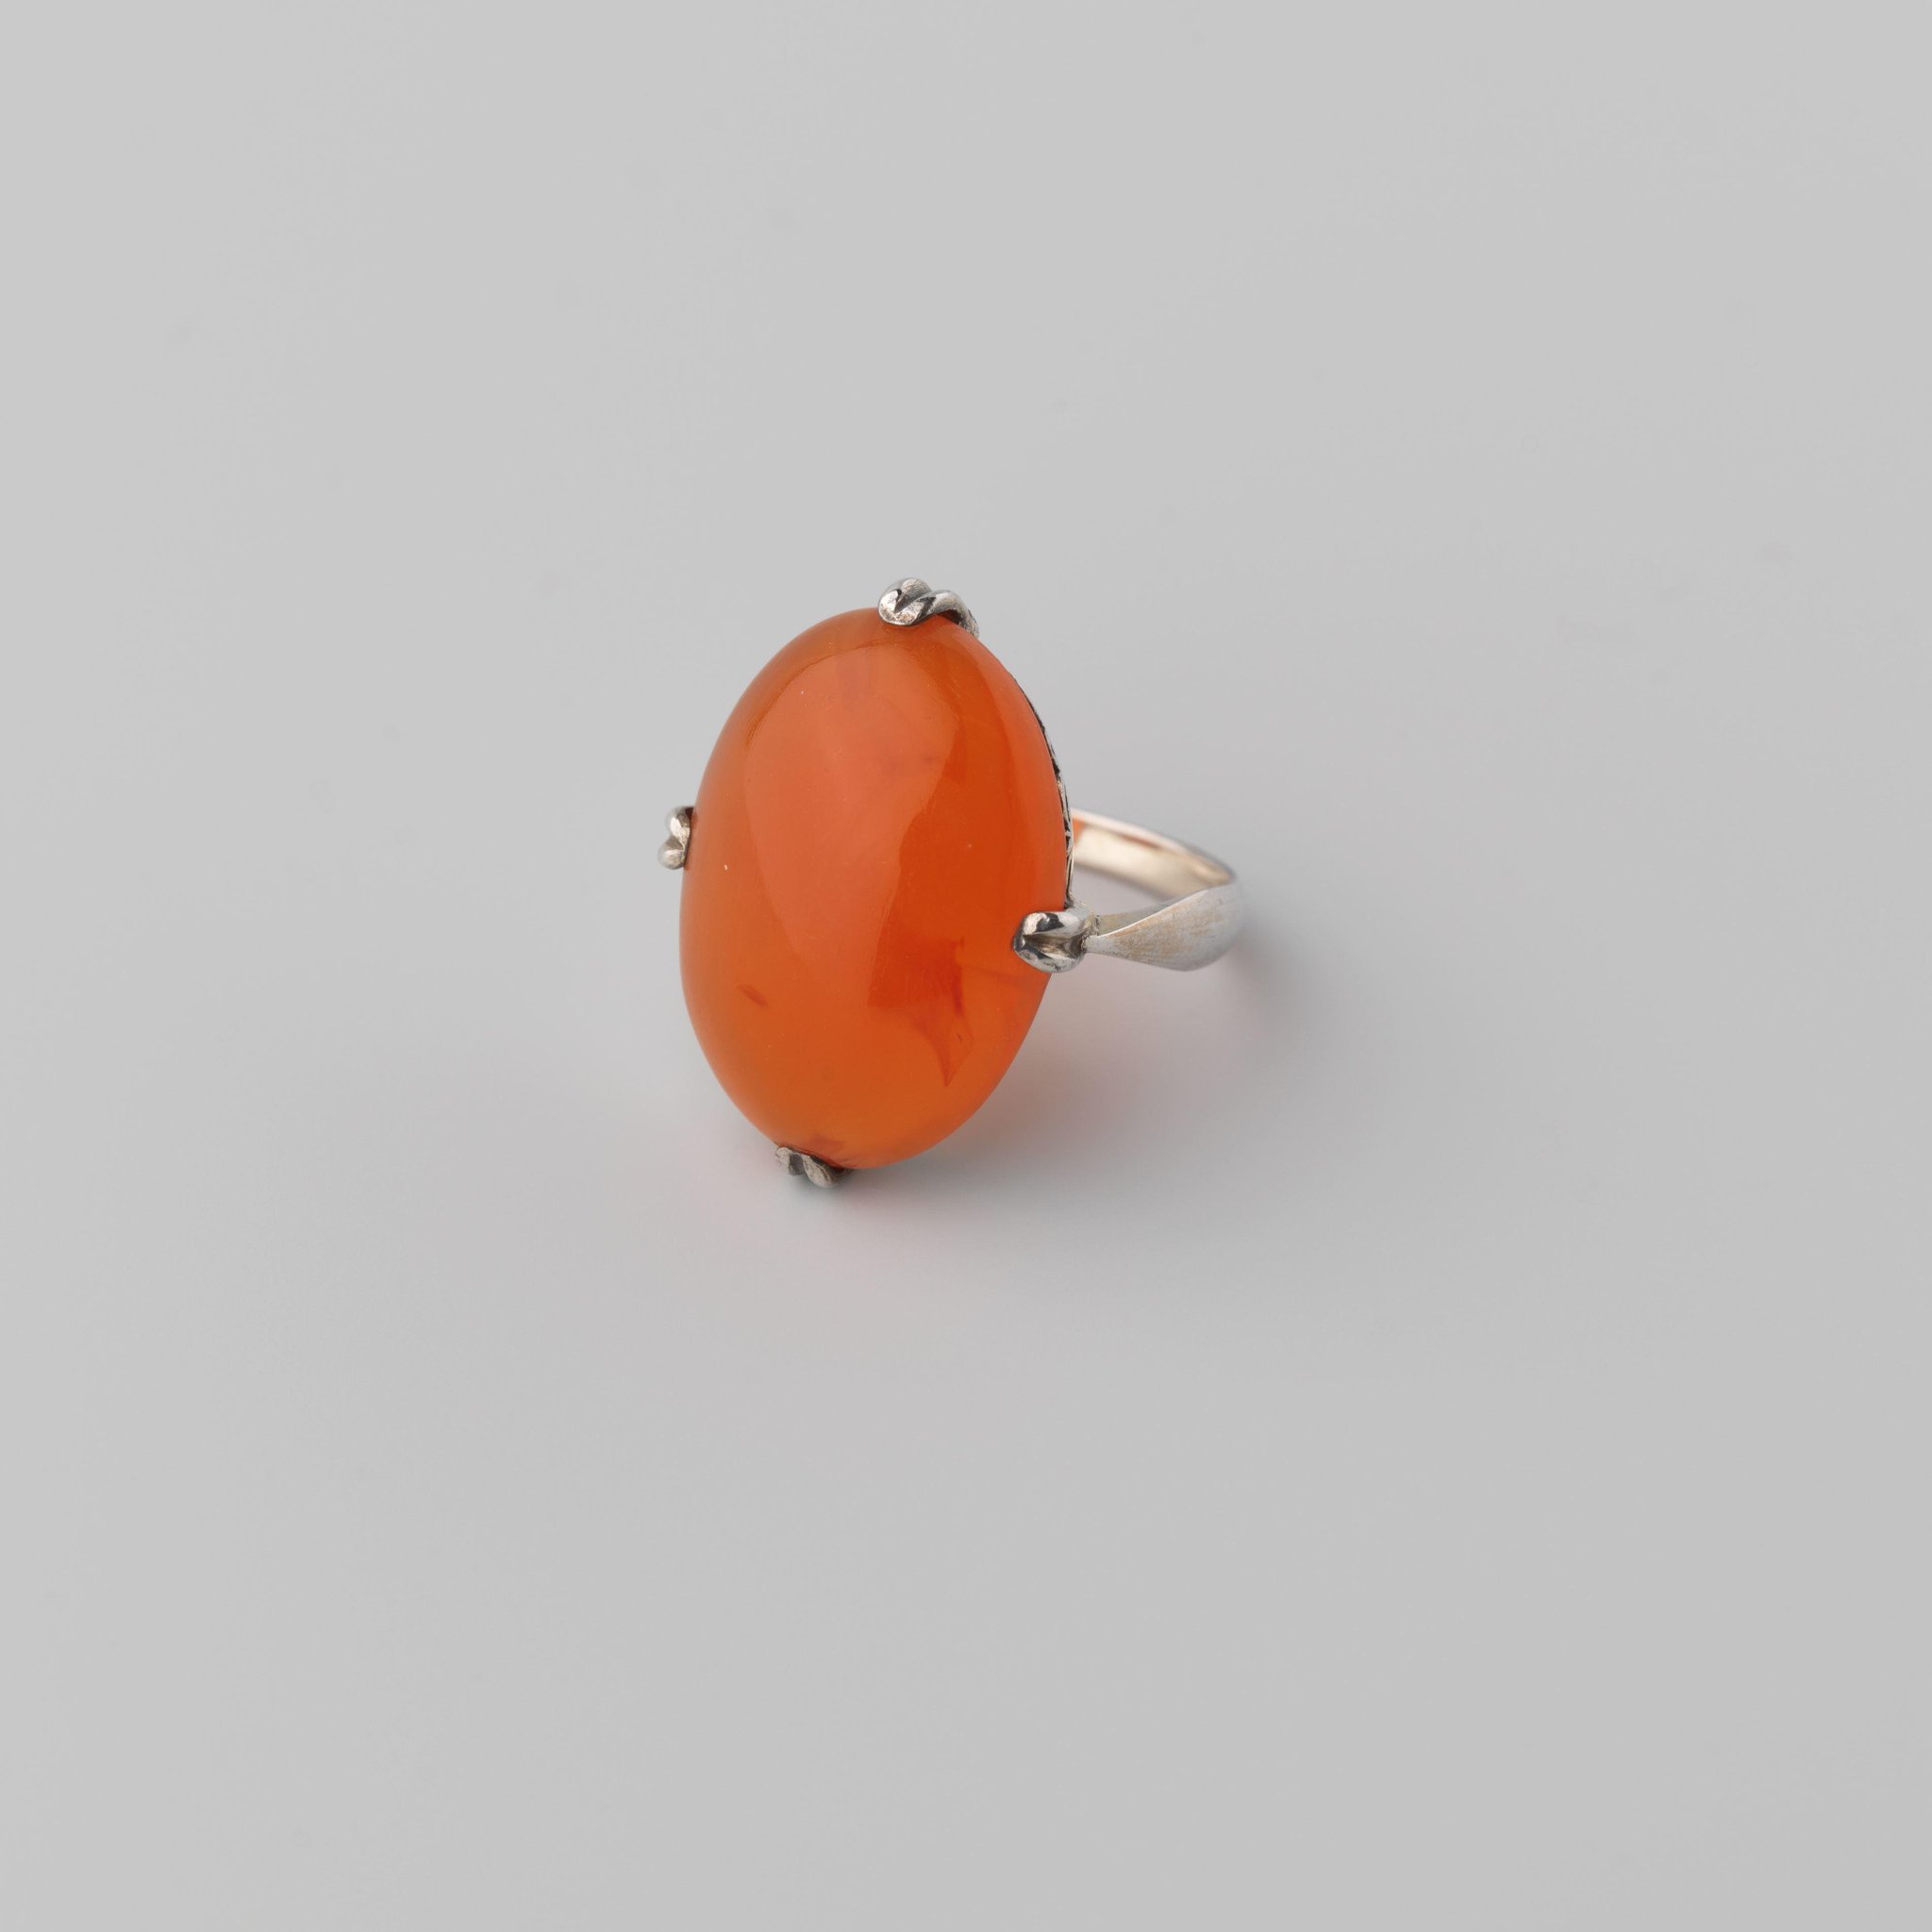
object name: ring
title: Ring van zilver met carneool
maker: Anonymous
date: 1940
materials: gemstone, silver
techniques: grinding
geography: netherlands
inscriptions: maker's mark: ‘LC’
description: Ring van zilver met een ovaal cabochon geslepen carneool. De zetting is opengewerkt.